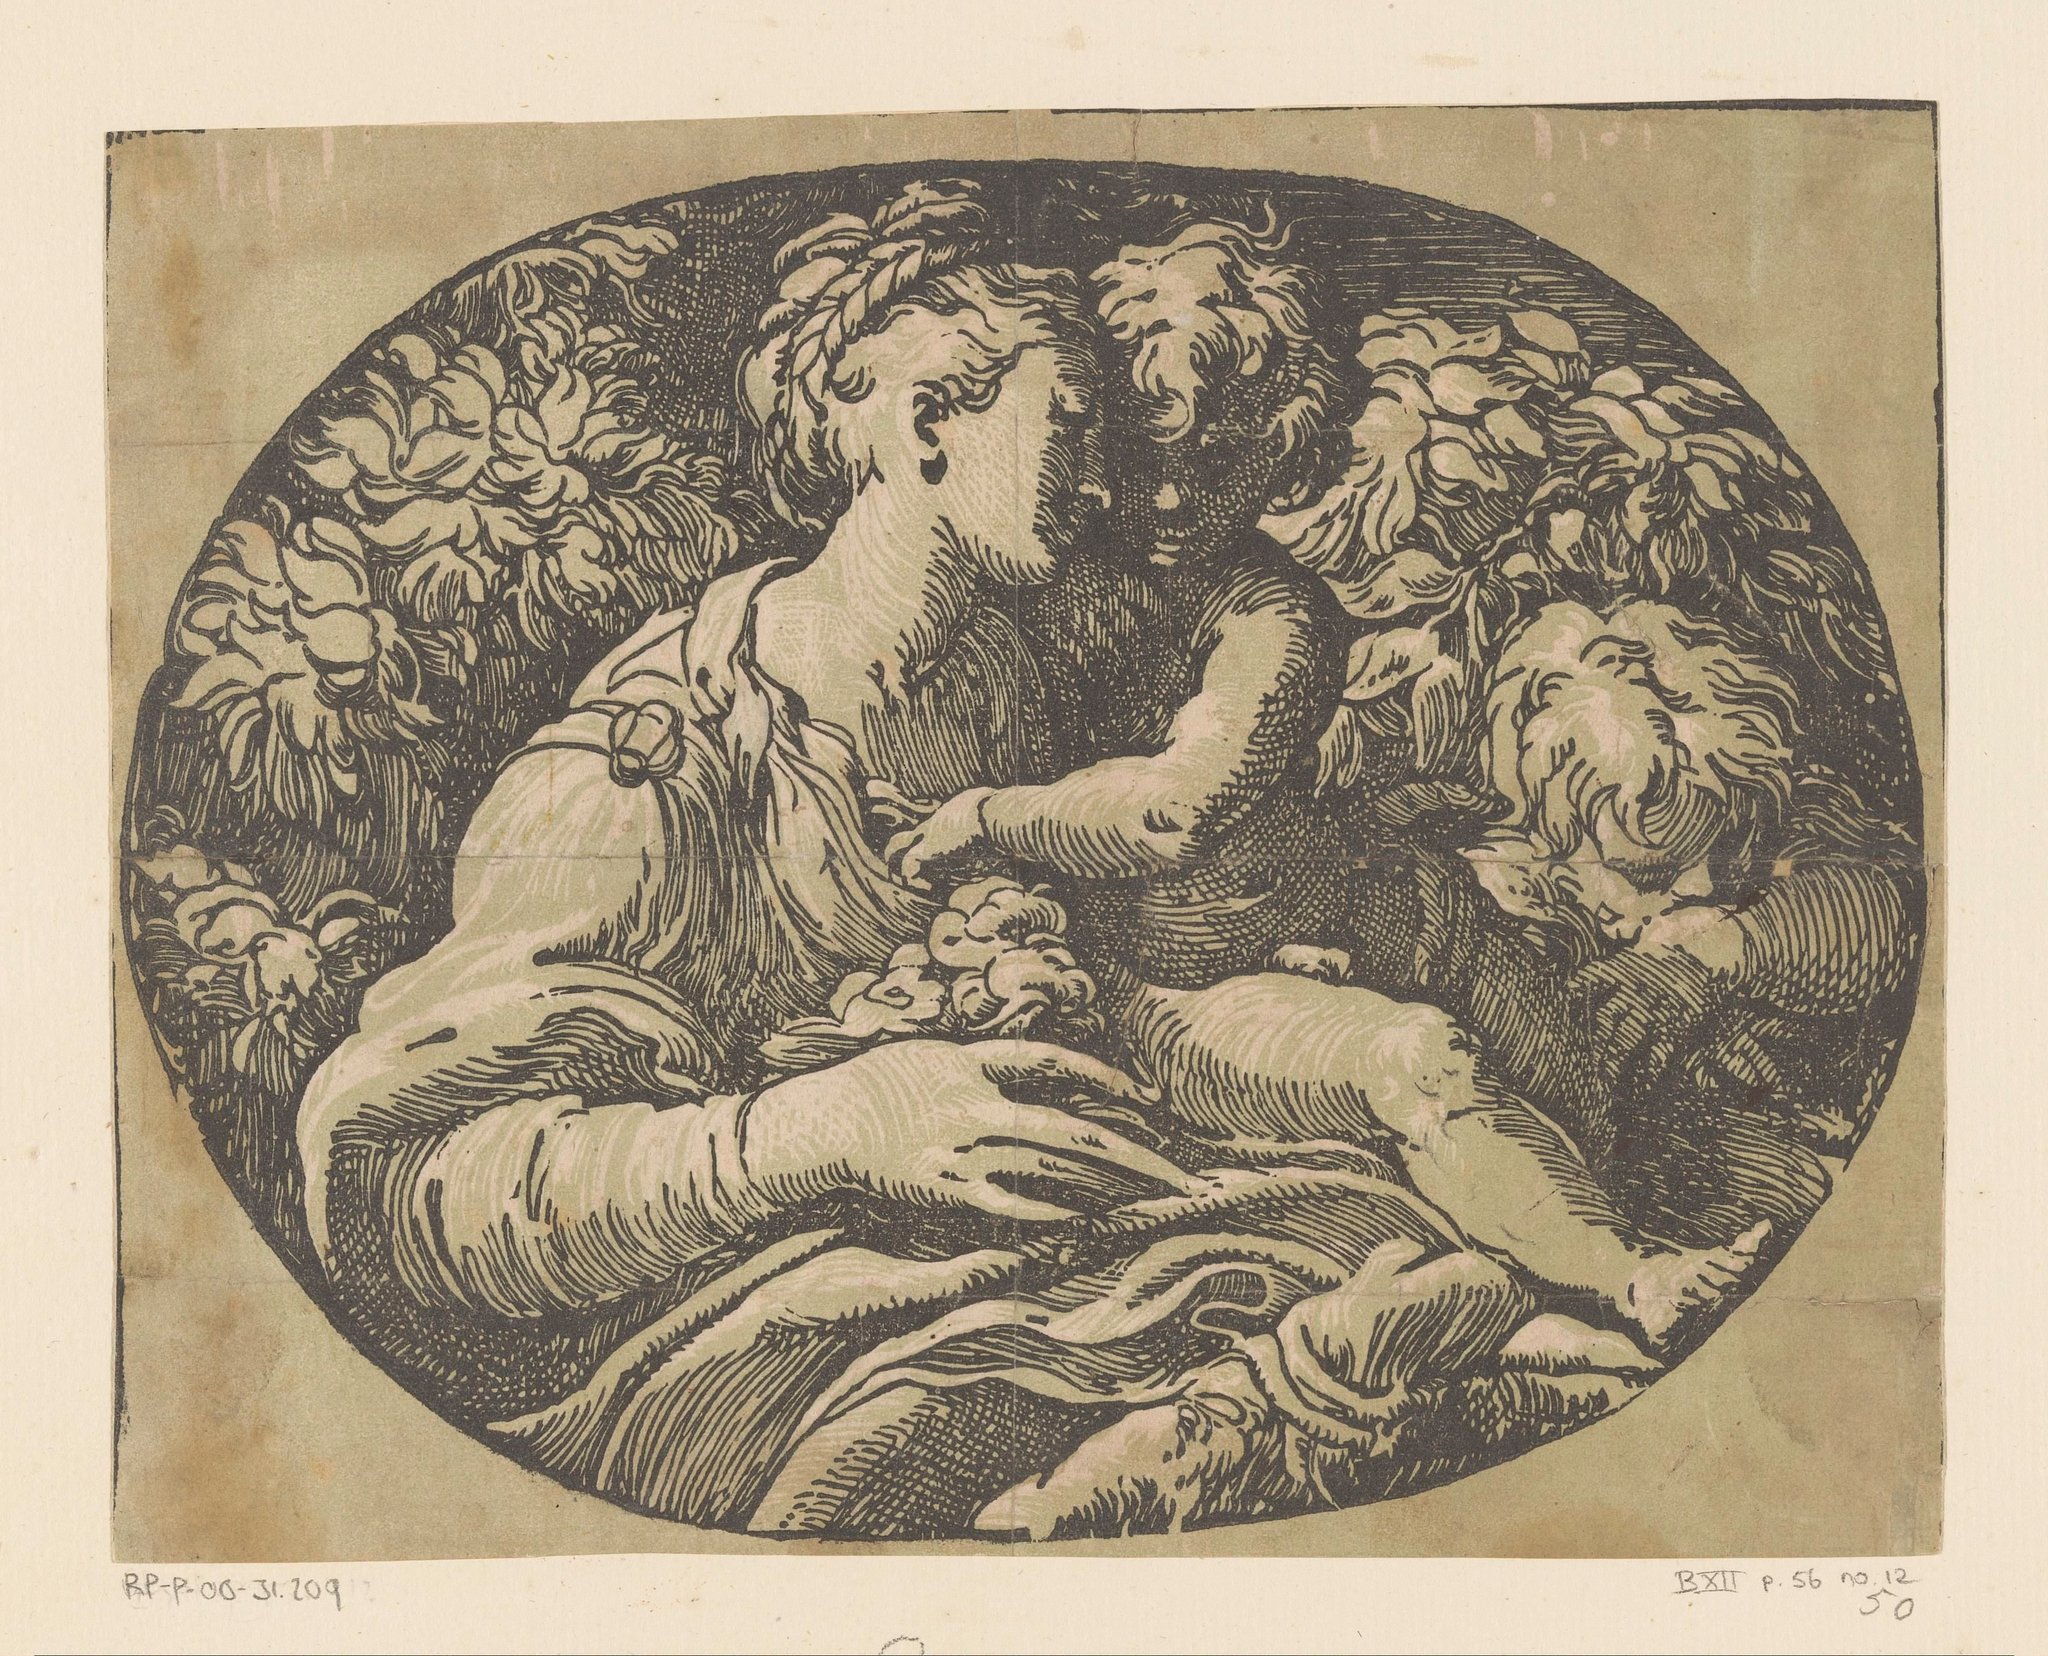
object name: print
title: Maria met de roos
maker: antonio da trento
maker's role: painter, print maker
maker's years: 1510-1550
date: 1520-1550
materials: paper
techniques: woodcut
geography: italy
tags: mary and the christ-child with john the baptist (as child), mary sitting or enthroned, the christ-child on her knee (christ-child to mary's left)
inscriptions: collector's mark: Lugt 240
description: Maria met op schoot het Christuskind en in haar hand een bos rozen. Rechts de jonge Johannes de Doper.